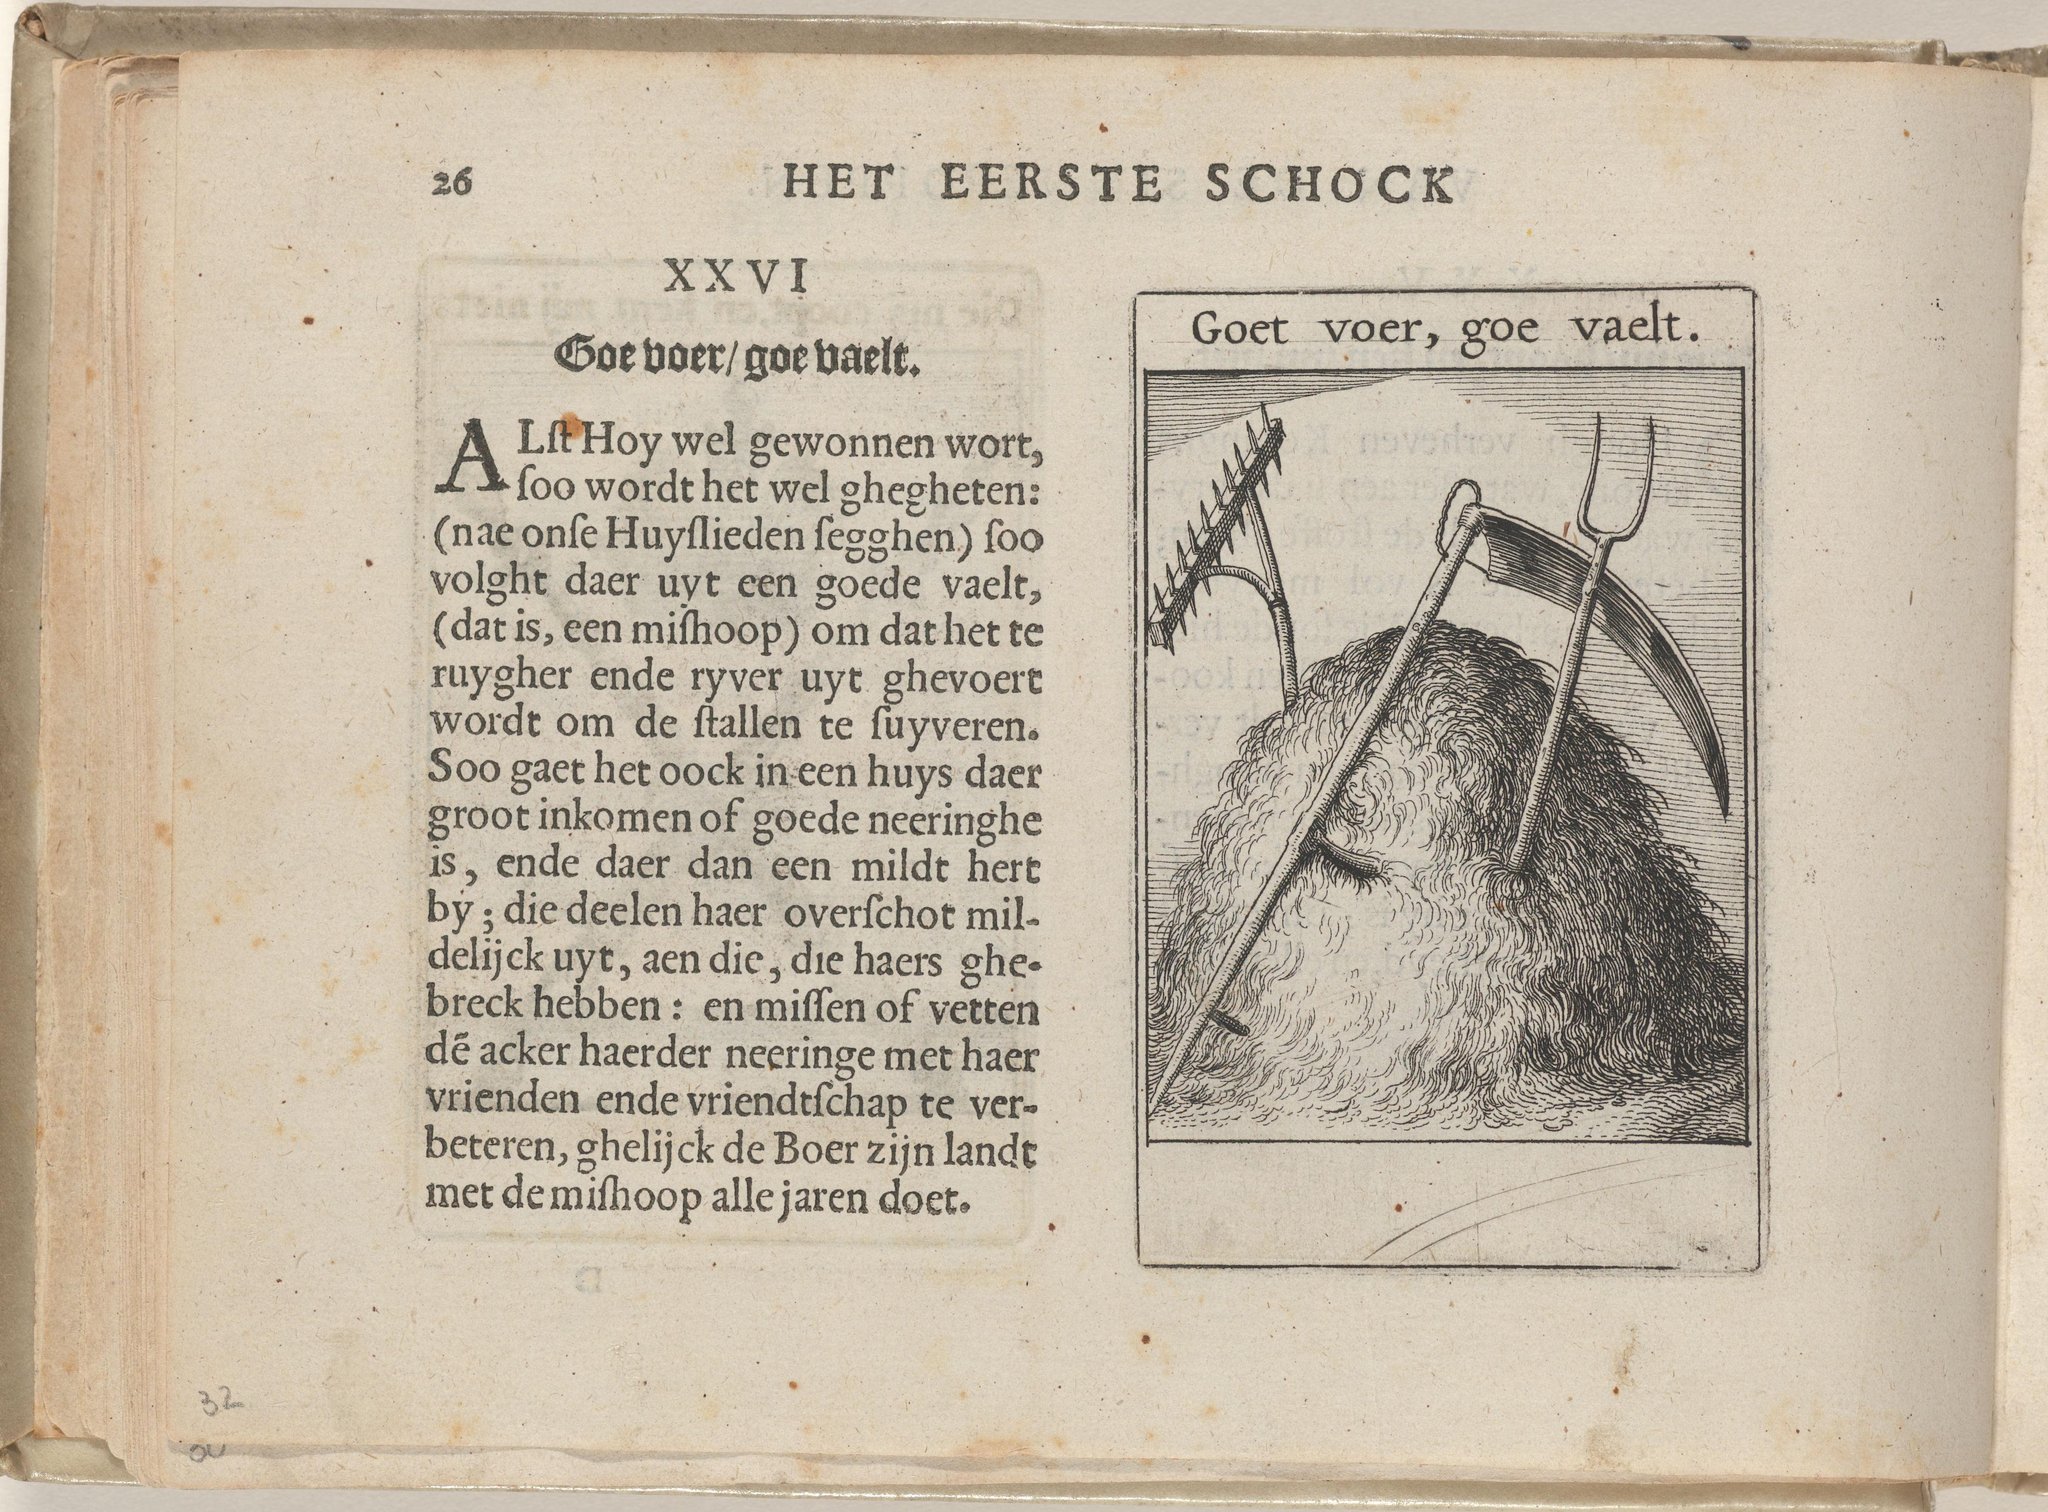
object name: album leaf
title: XXVI Goet voer, goe vaelt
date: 1614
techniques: engraving, printing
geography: amsterdam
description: XXVI Goet voer, goe vaelt. Eerste schok. Onderdeel van 'Sinnepoppen', R. Visscher, 1614.